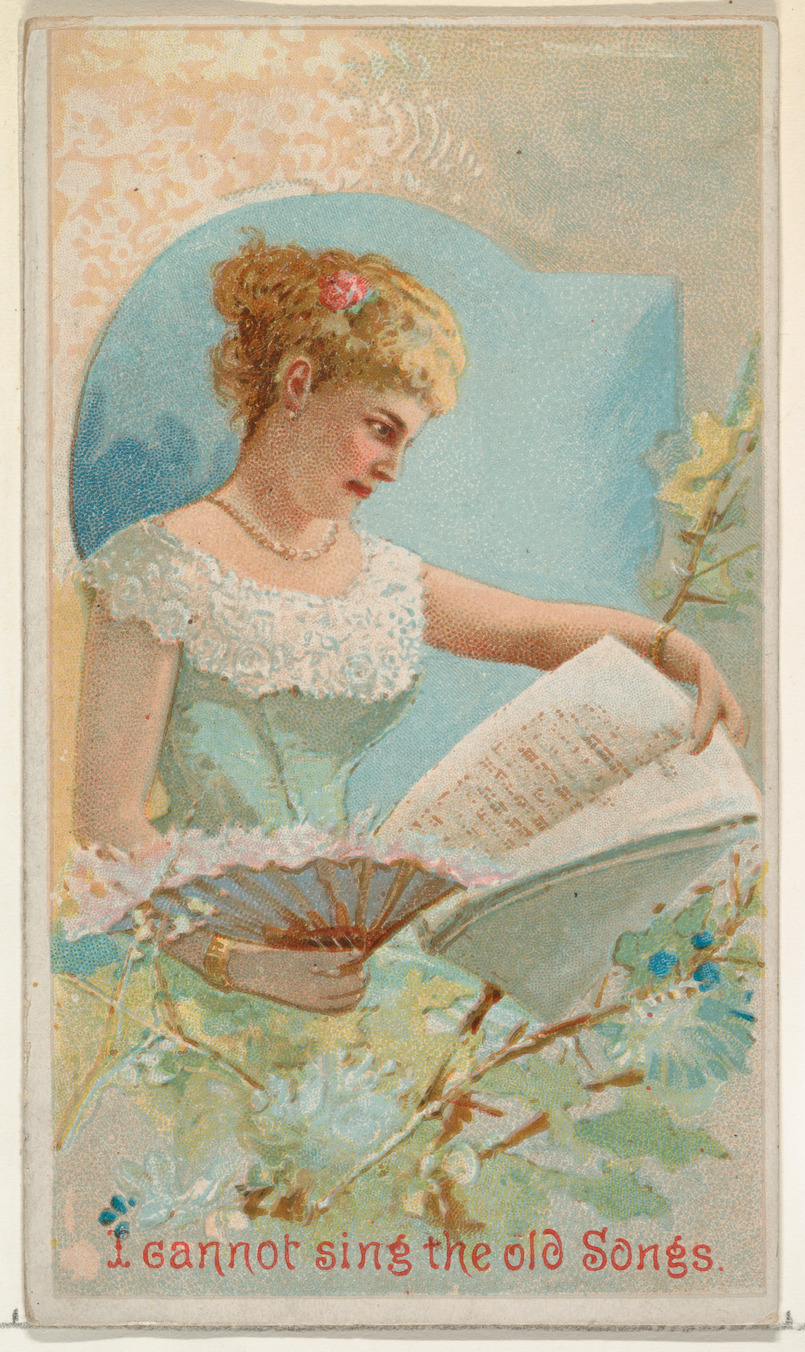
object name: print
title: I Cannot Sing the Old Songs, from the Illustrated Songs series (N116) issued by W. Duke, Sons & Co. to promote Honest Long Cut Tobacco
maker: w. duke, sons & co.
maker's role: publisher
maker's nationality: american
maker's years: 1870-1920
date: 1893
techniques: color lithograph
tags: profiles,women,reading